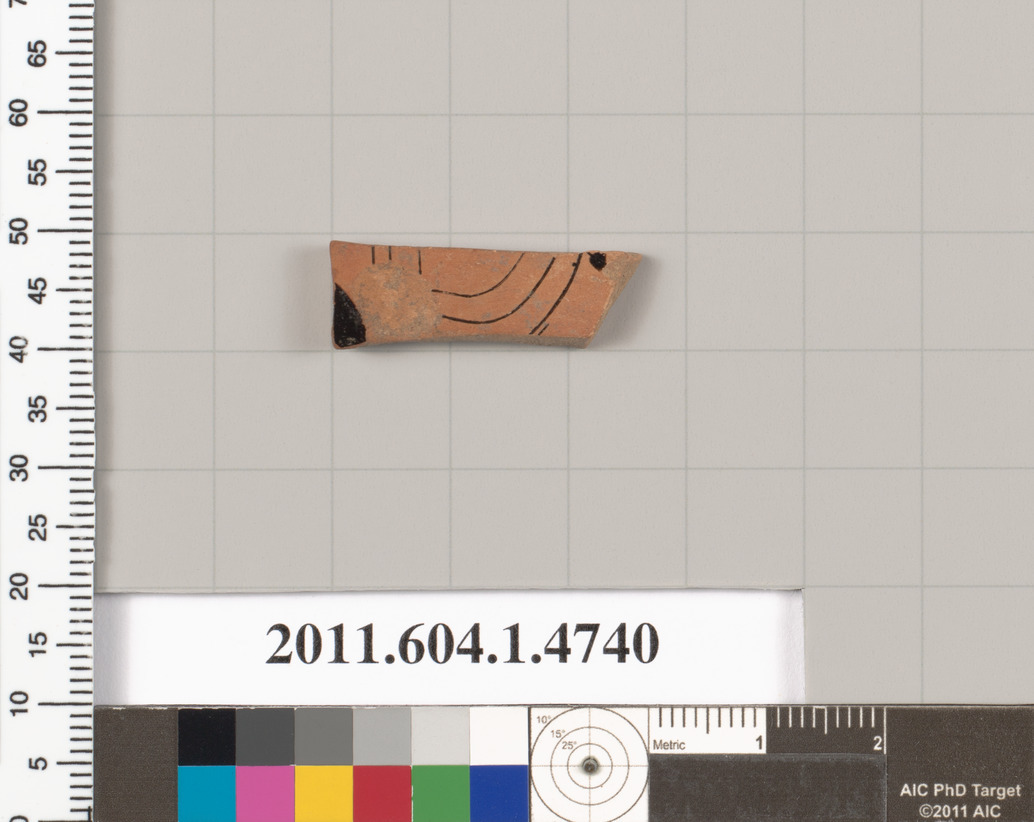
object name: kylix fragment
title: Terracotta fragment of a kylix (drinking cup)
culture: greek, attic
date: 475-451 BCE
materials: terracotta